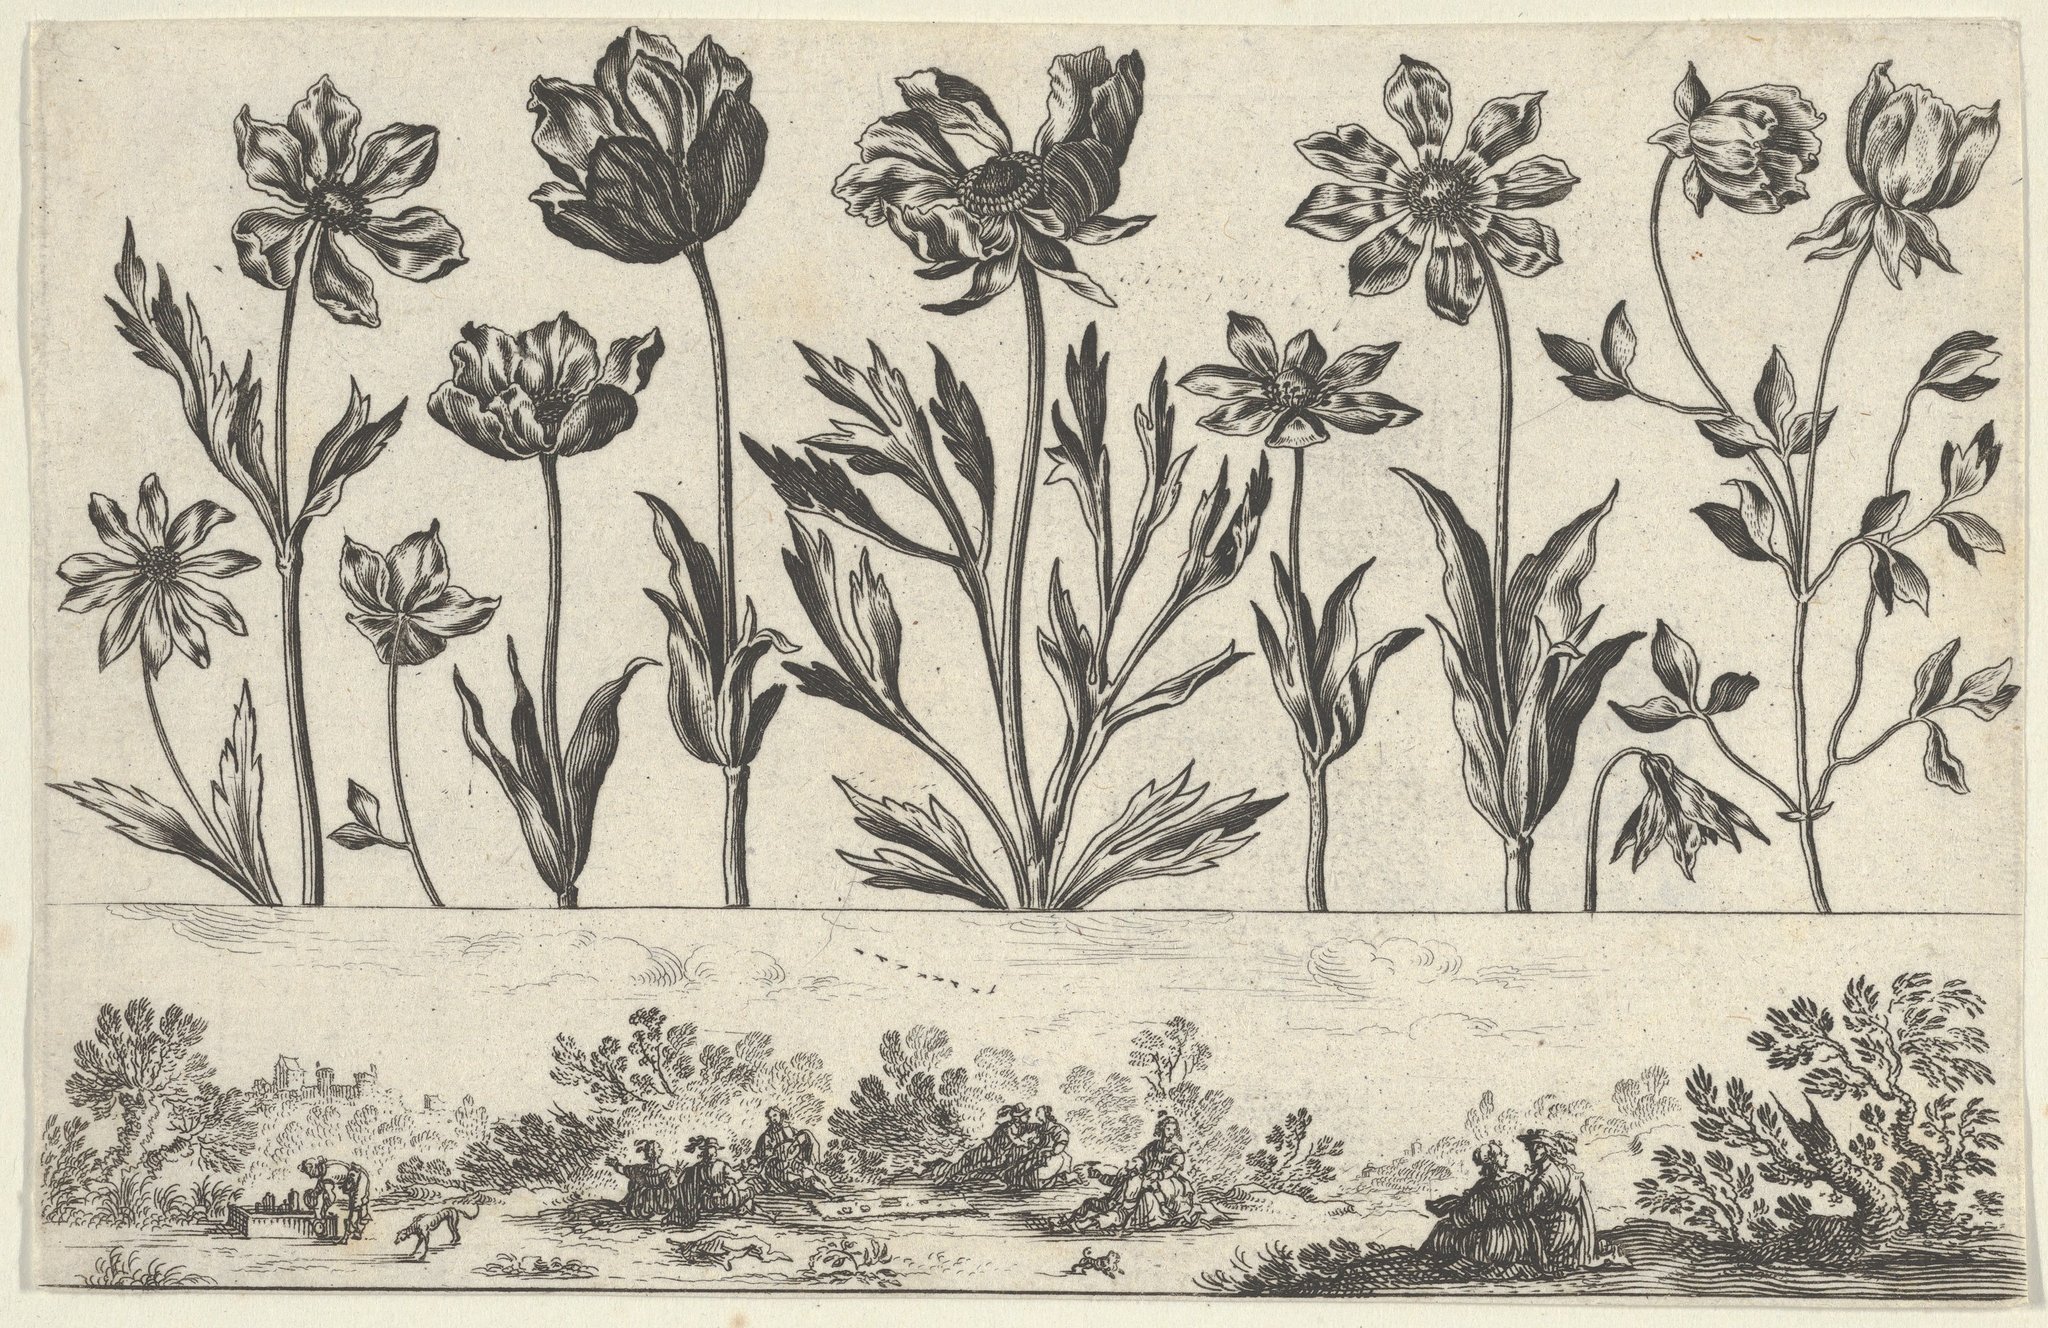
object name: print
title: Horizontal Panel with a Row of Flowers Above a Frieze with Figures in a Landscape, from "Livre Nouveau de Fleurs Tres-Util"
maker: nicolas cochin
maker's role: artist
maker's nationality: french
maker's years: 1610-1686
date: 1645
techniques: engraving, etching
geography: france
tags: flowers,landscapes